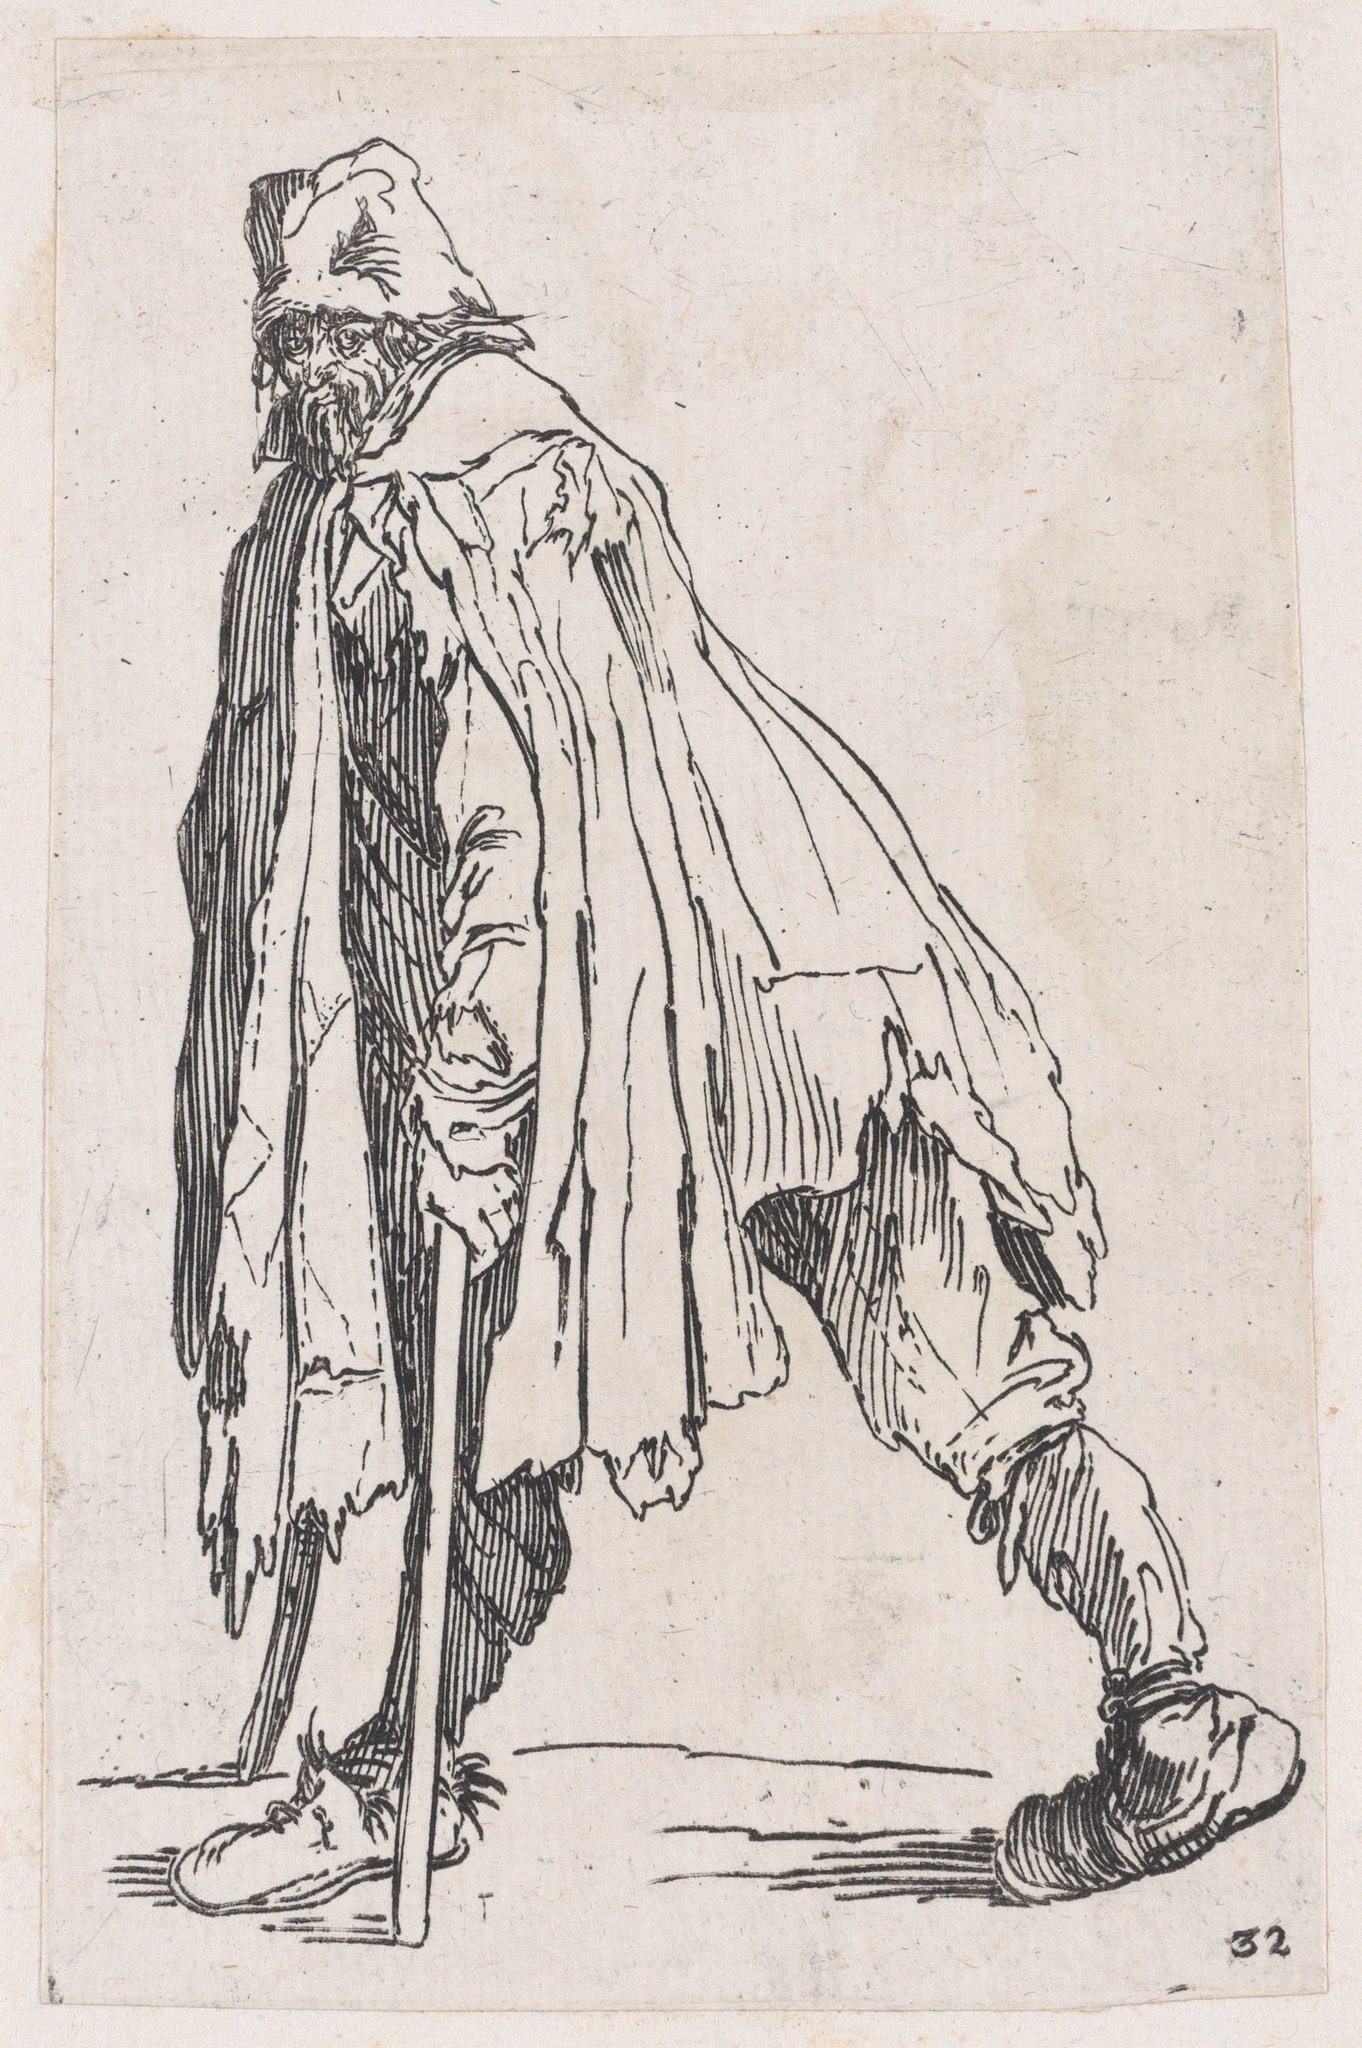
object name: print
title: Reverse Copy of Le Mendiant aux Béquilles Coiffée d'un Chapeau et Vu de Dos (The Beggar with Crutches Wearing a Hat and Viewed from Behind), from Les Gueux suite appelée aussi Les Mendiants, Les Baroni, ou Les Barons (The Beggars, also called the Barons)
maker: Anonymous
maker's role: artist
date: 1601-1700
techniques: etching